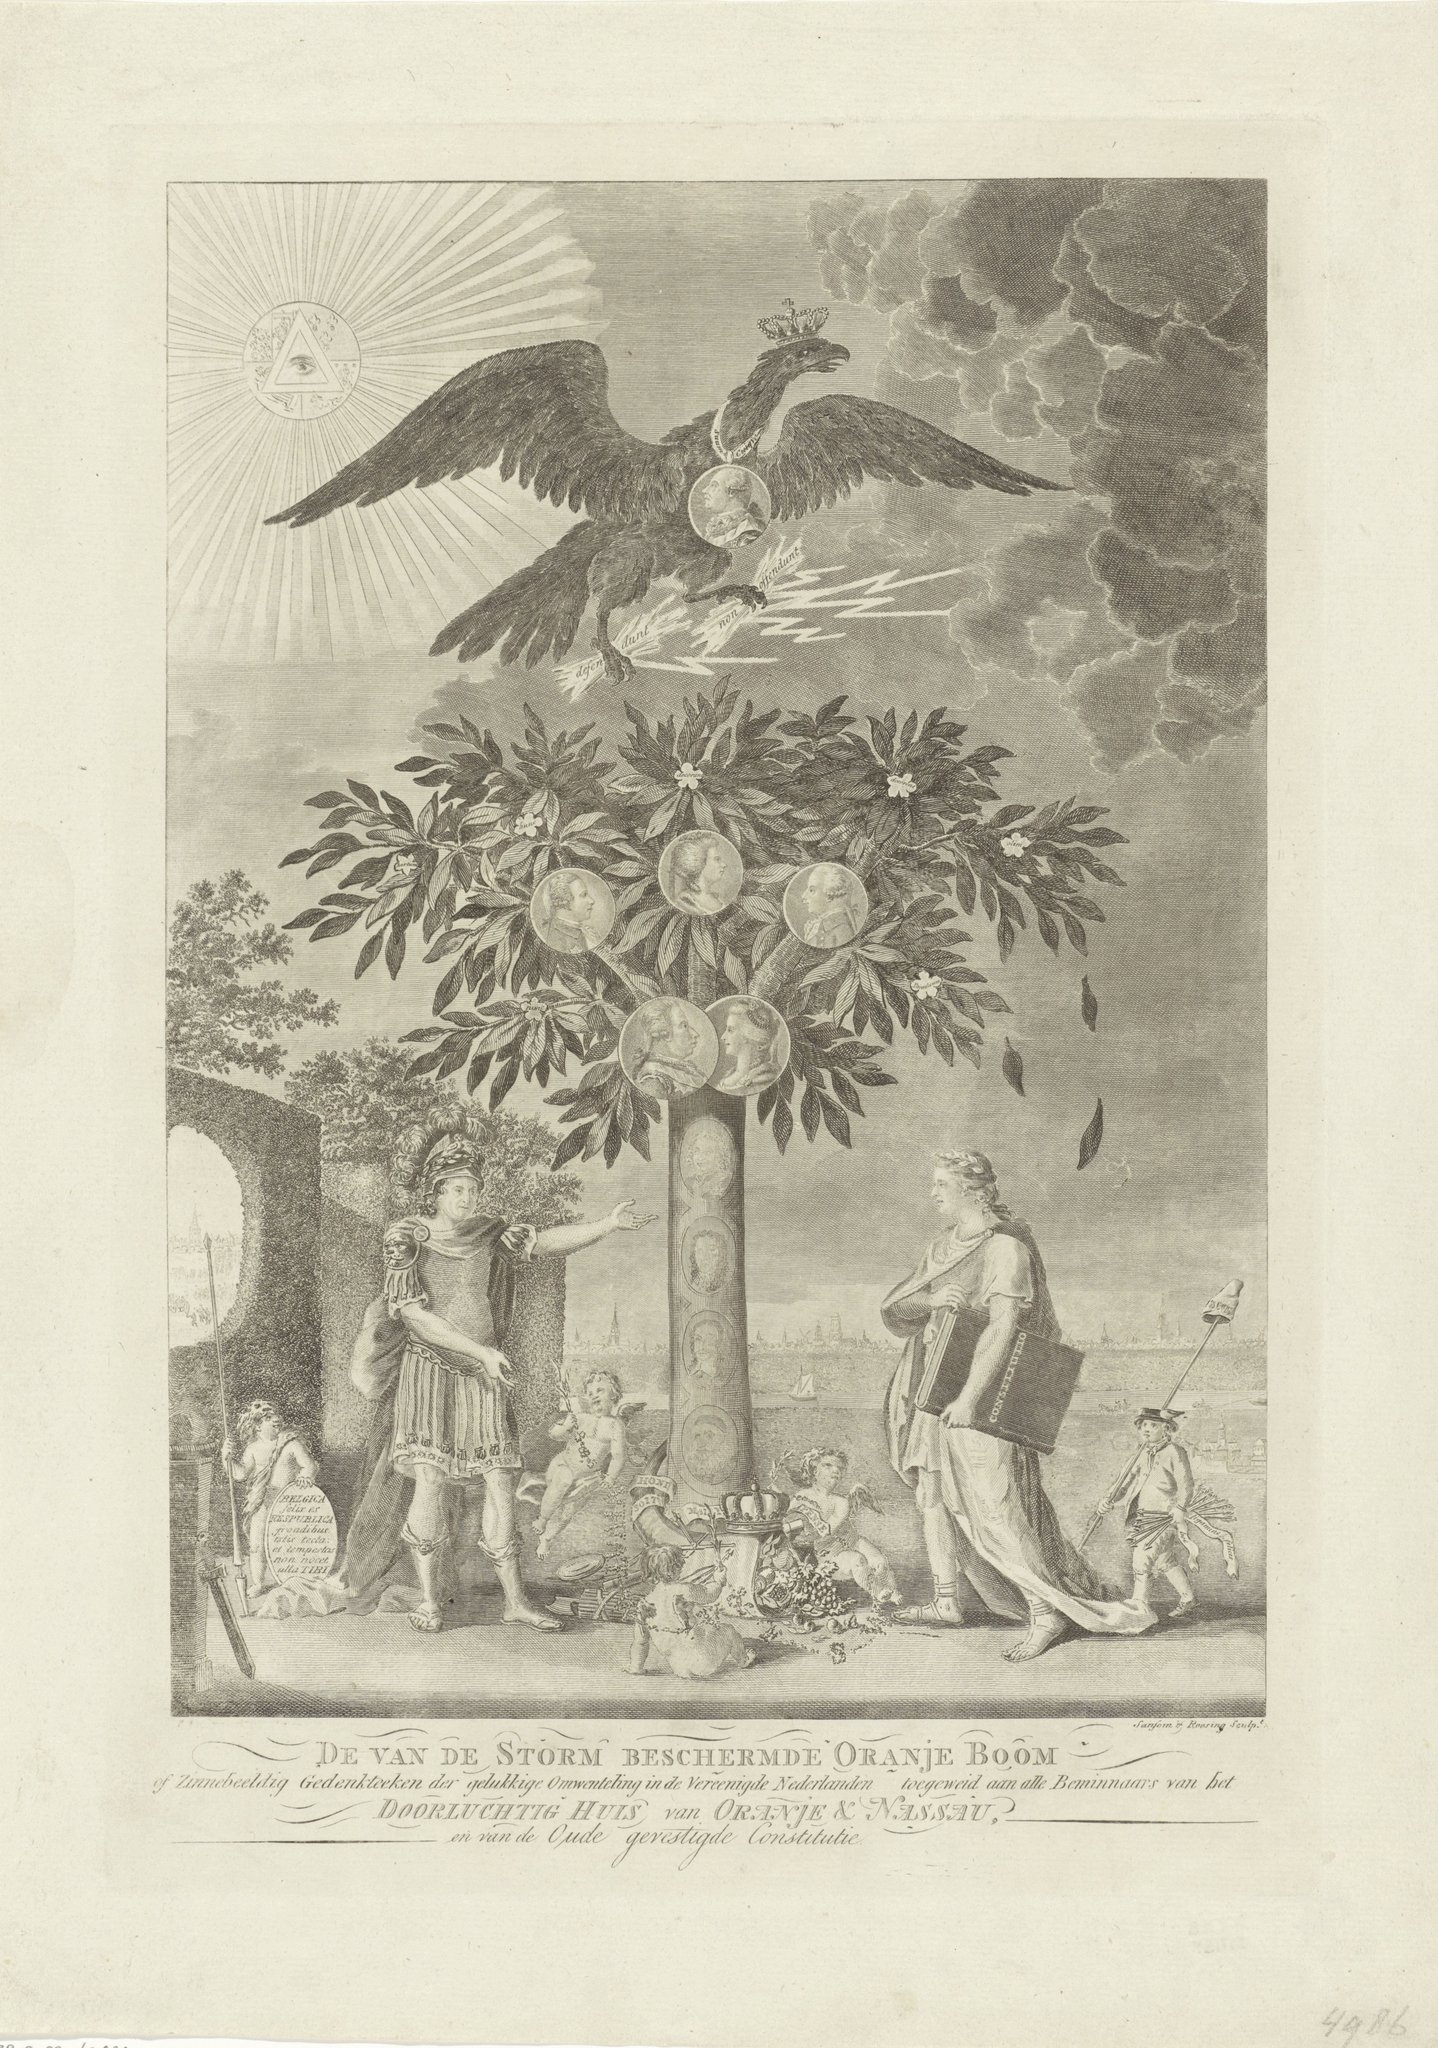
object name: print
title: De van de storm beschermde oranje boom of zinnebeeldig gedenkteeken der gelukkige omwenteling in de Vereenigde Nederlanden (...)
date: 1787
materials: paper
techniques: engraving, etching, roulette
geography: northern netherlands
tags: the hague, william v (prince of orange), karel willem ferdinand hertog van brunswijk-wolfenbüttel, berlin, painter, draughtsman, wilhelmina of prussia (princess of orange), predatory birds: eagle, the all-seeing eye, triangle with eye ~ symbol of god the father, homage to a ruler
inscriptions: collector's mark: Lugt 2165, collector's mark: Lugt 963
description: In het midden de Oranjeboom met daarin medaillons met de portretten van de stadhouder, zijn gemalin en kinderen en (aan de stam) die van zijn voorouders Willem I t/m IV. Op de bloemen staan Latijnse woorden. De boom wordt beschermd door de Pruisische adelaar. Linksboven het Alziend Oog. Links staat de hertog van Brunswijk-Wolfenbüttel in de gedaante van Mars. Bij hem staat links een putto met een schild als Hercules en rechts een putto met een bloemenslinger, die een Latijnse tekst en enkele initialen vormt. Onder hem fasces. Verder nog twee putti bij de boom. Rechts graaf Bentinck als de Republiek met de constitutie in boekvorm onder zijn arm en de wapens van Zeeland en Holland op zijn gewaad. Achter hem Mercurius met de vrijheidsmuts op een speer en de zeven pijlen van de provincies. In de verte een rivier met enkele stadsgezichten.